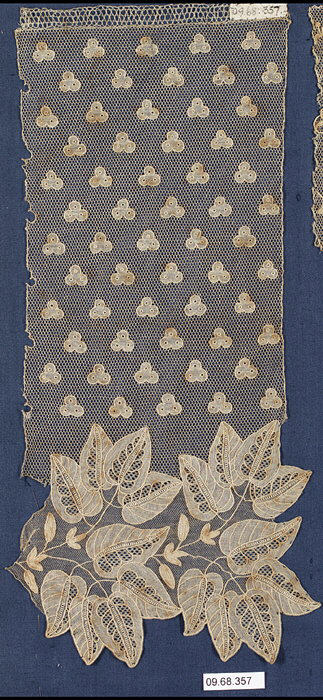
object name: fragment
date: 1801-1900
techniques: lace